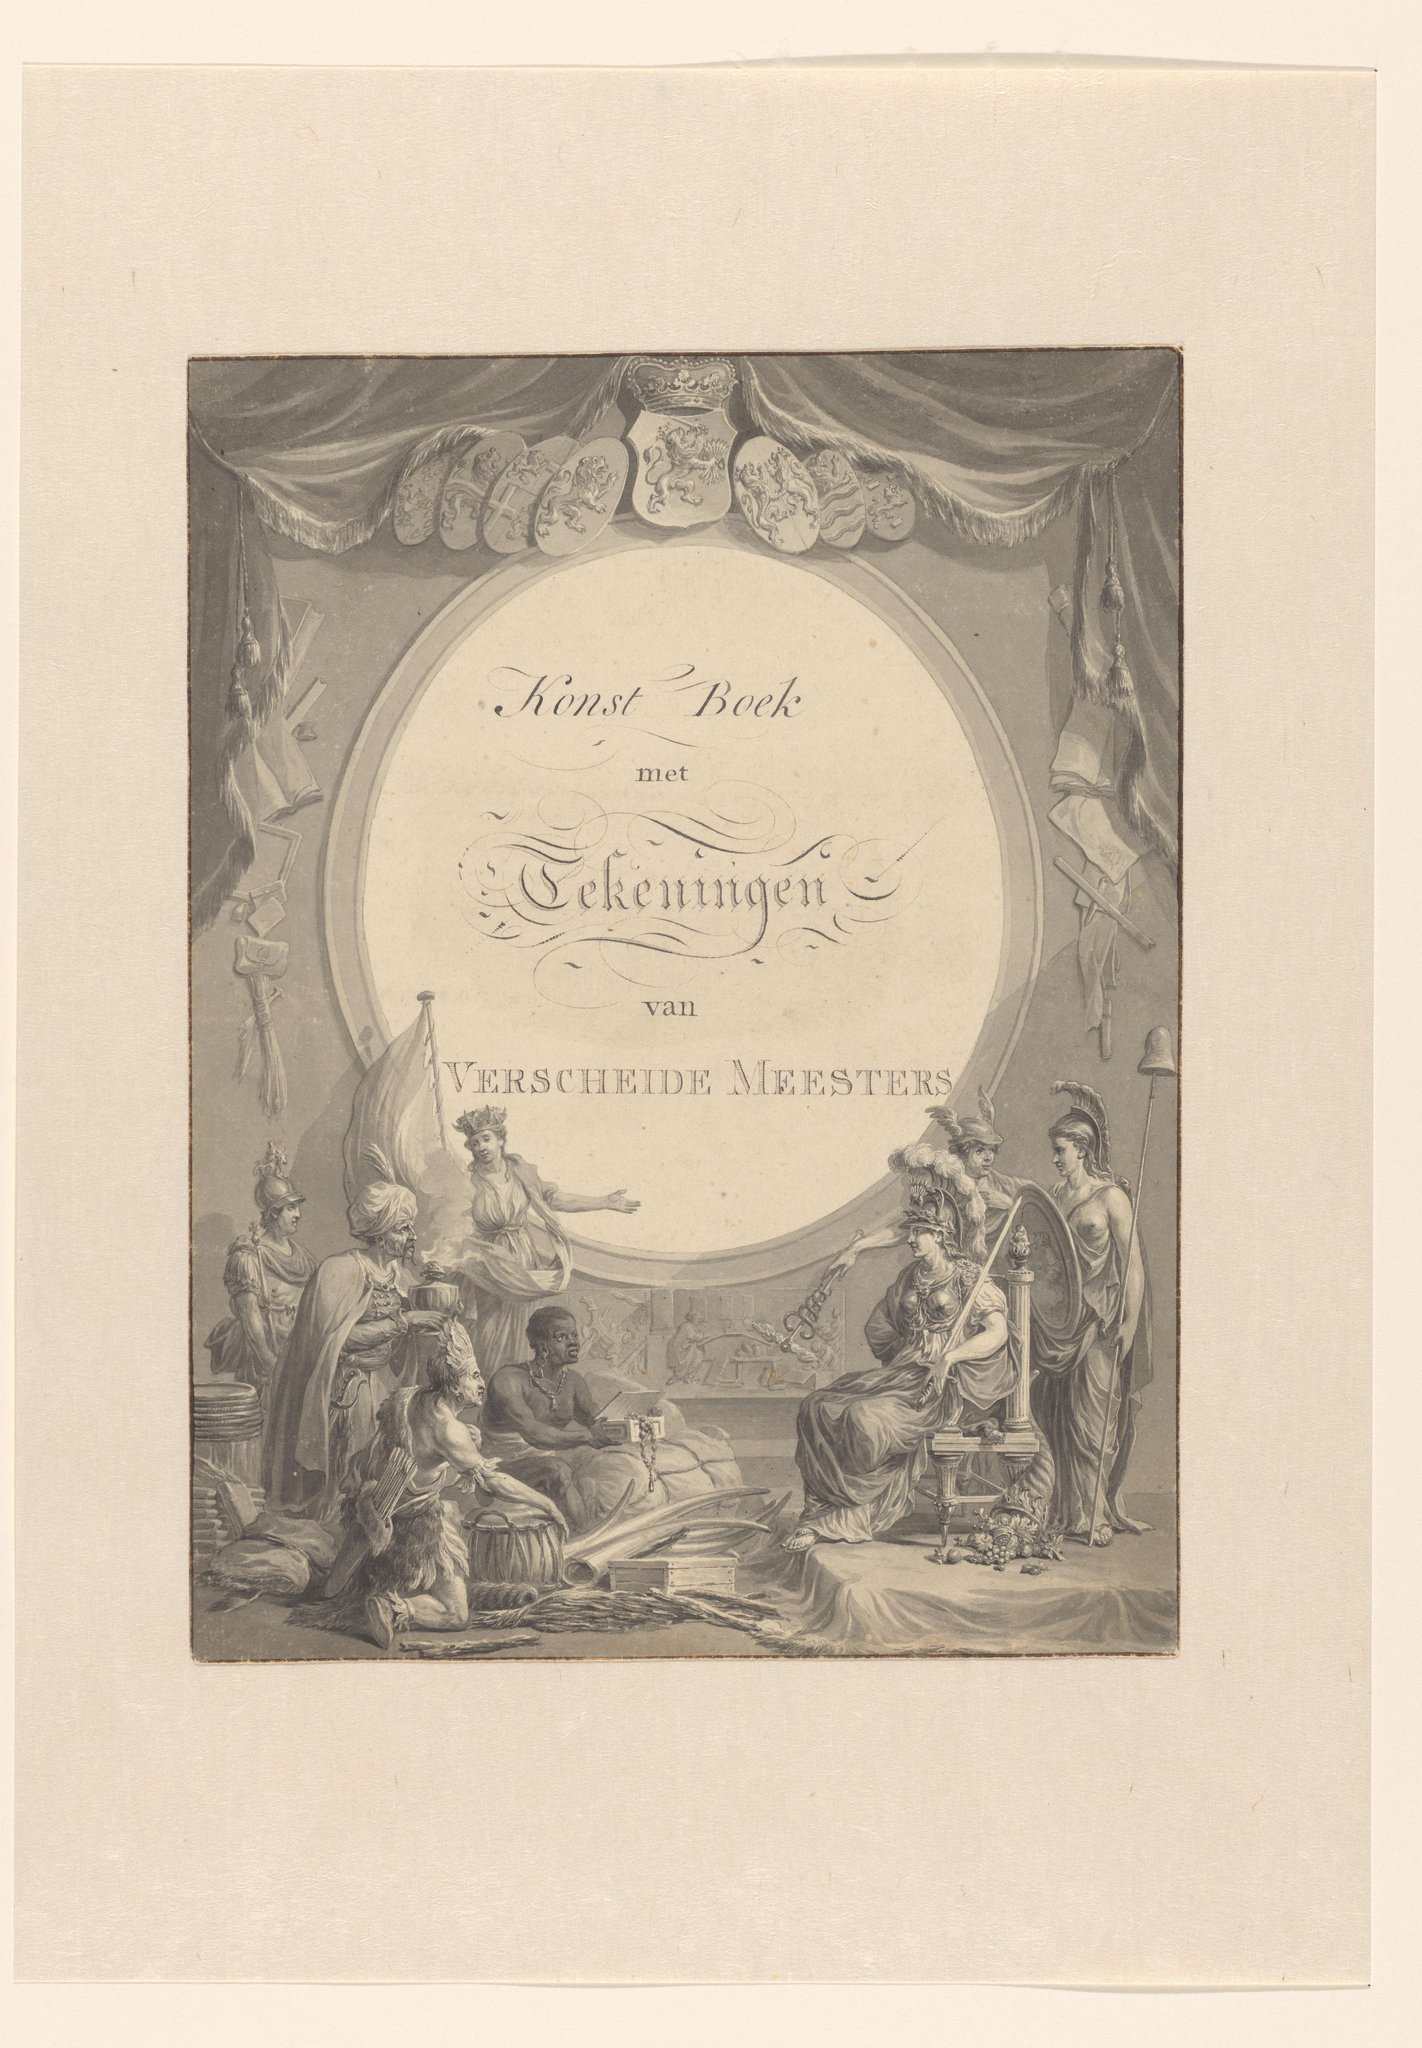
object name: titelblad, titelpagina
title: Konst Boek met Tekeningen van Verscheide meesters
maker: dirk langendijk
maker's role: draughtsman, painter, print maker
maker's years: 1748-1805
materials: graphite, ink, paper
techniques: brush, pen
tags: (story of) minerva (pallas, athena)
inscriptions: annotation: ‘Konst Boek/ met/ Tekeningen/ van/ Verscheide meesters’